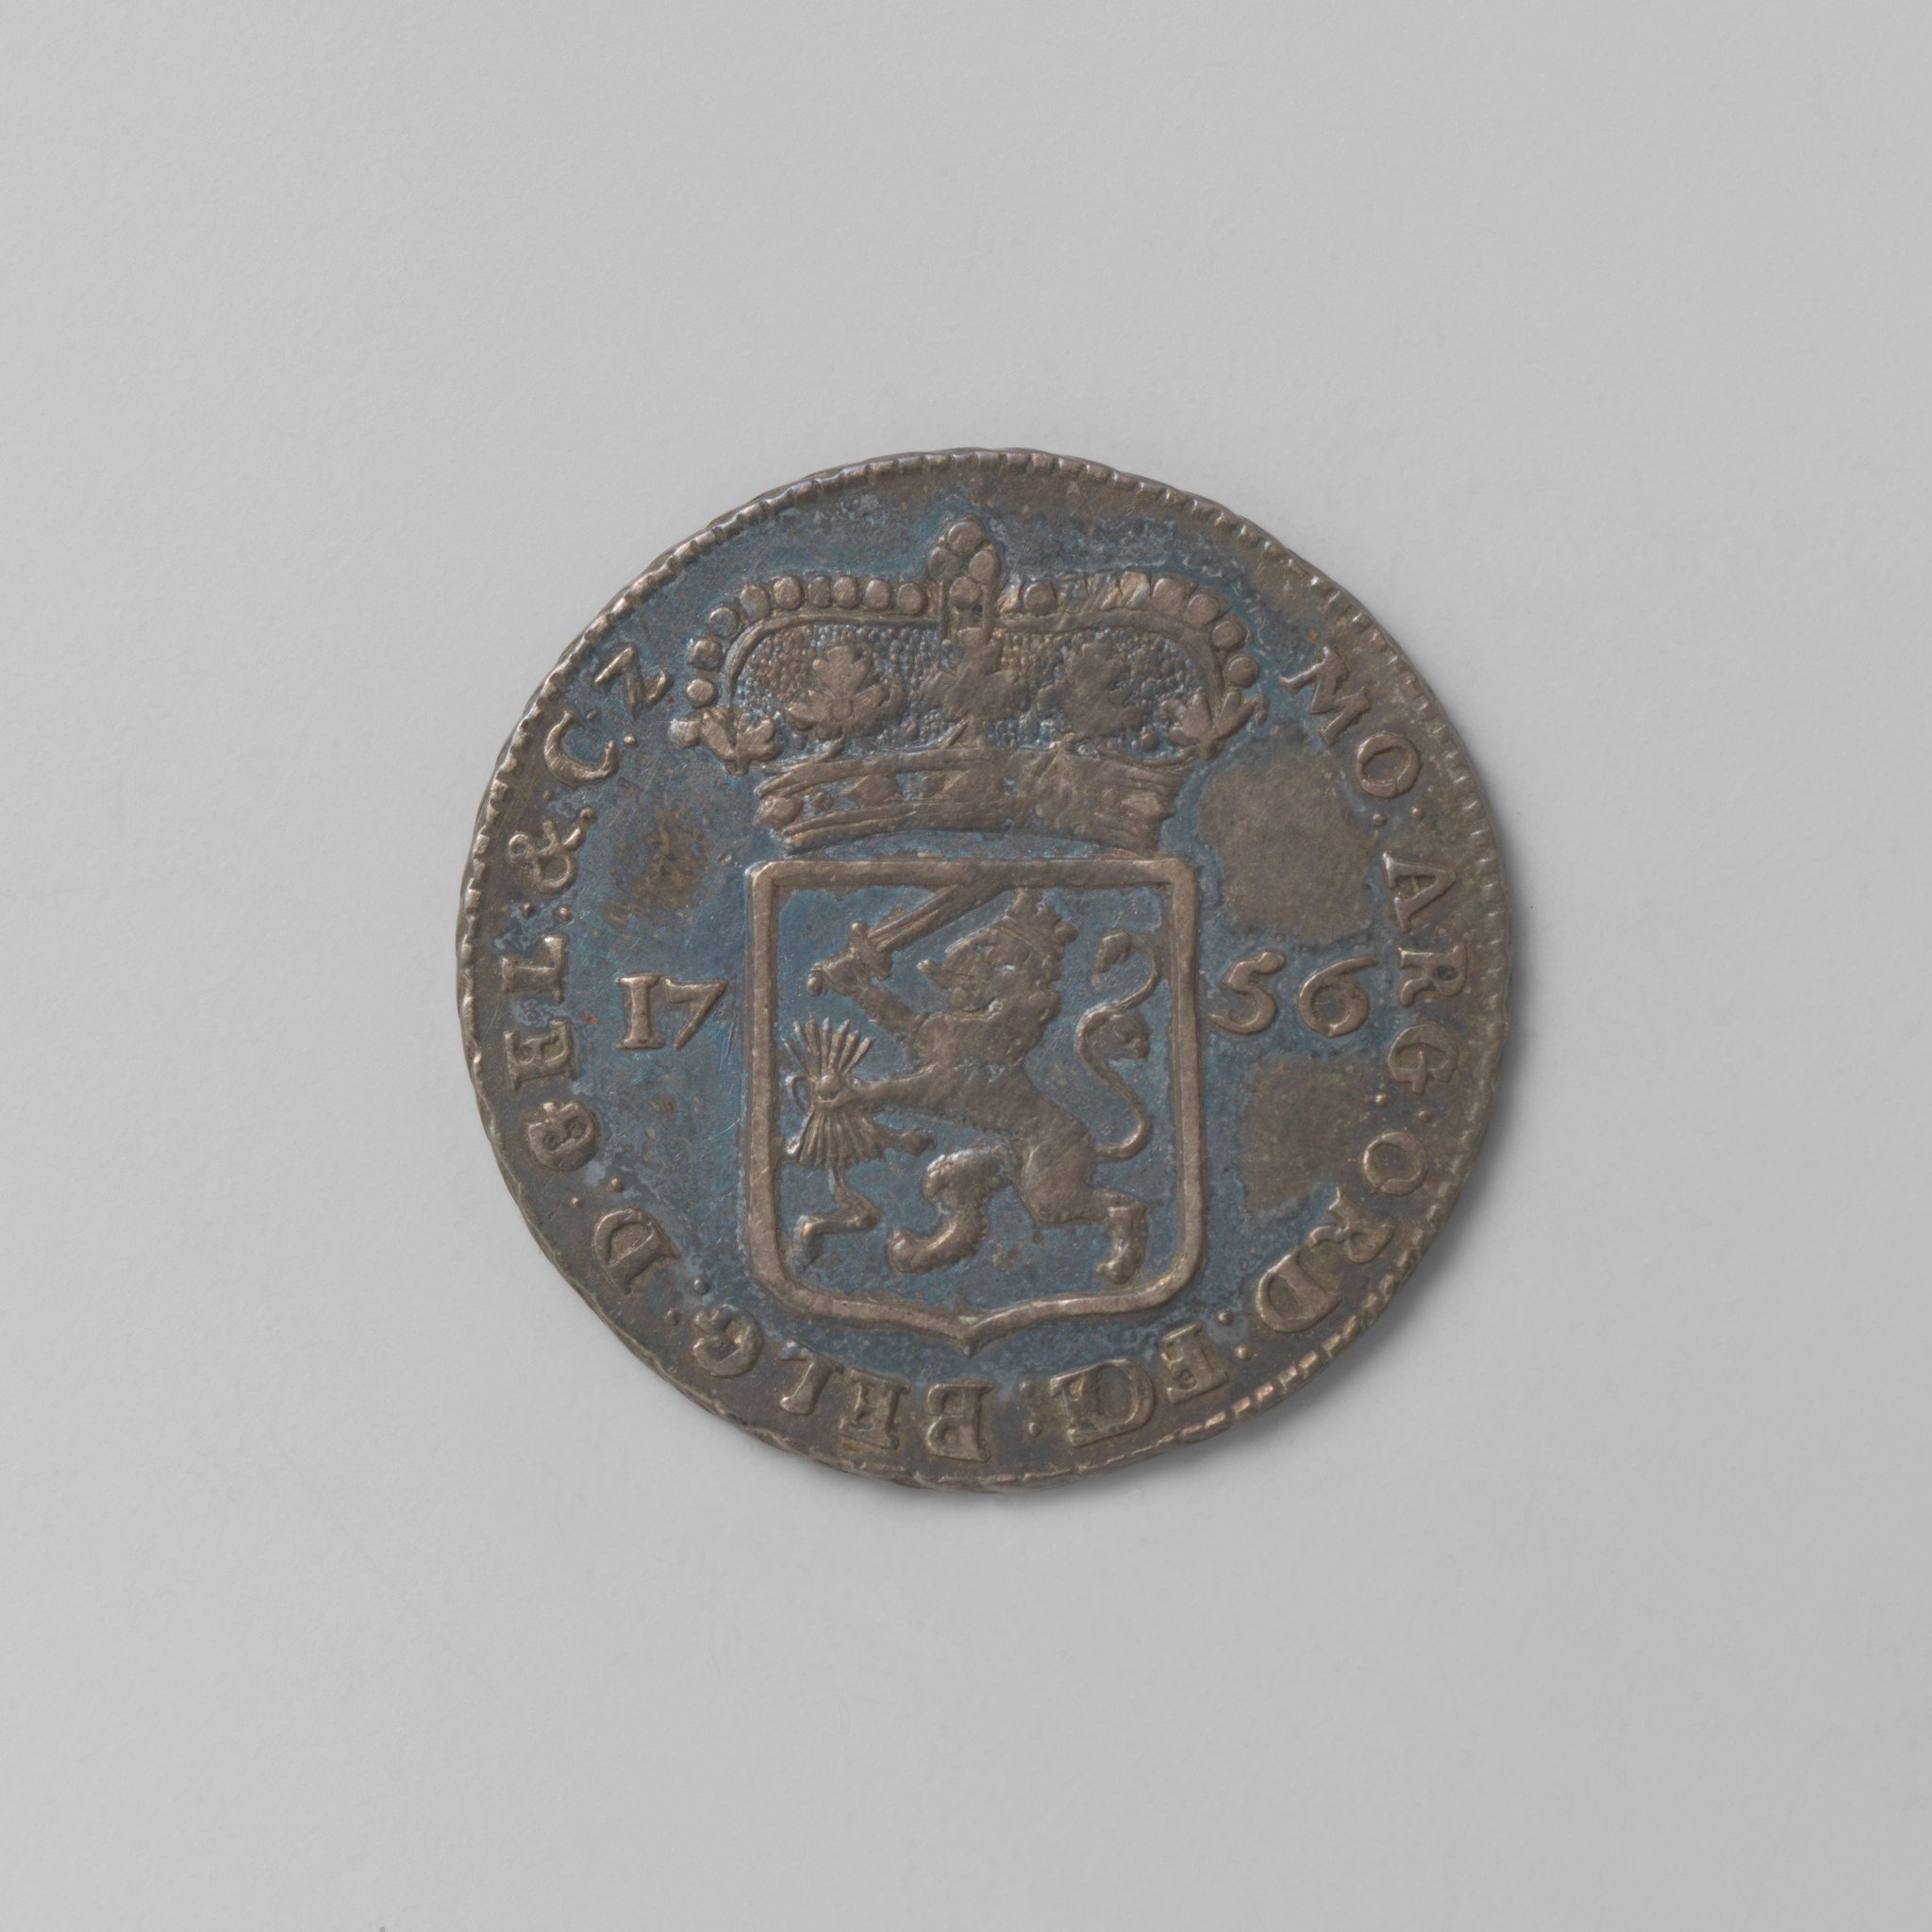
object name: coin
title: Gelderland, kwart gulden, 1756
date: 1756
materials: silver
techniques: striking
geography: harderwijk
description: Zilveren munt. Voorzijde: tussen jaartal gekroond generaliteitswapenschild. Keerzijde: staande Nederlandse maagd, in rechterhand lans met hoed, met linkerarm steunend op sokkel, waarop bijbel. Zogenaamde muntmeesterpenning.